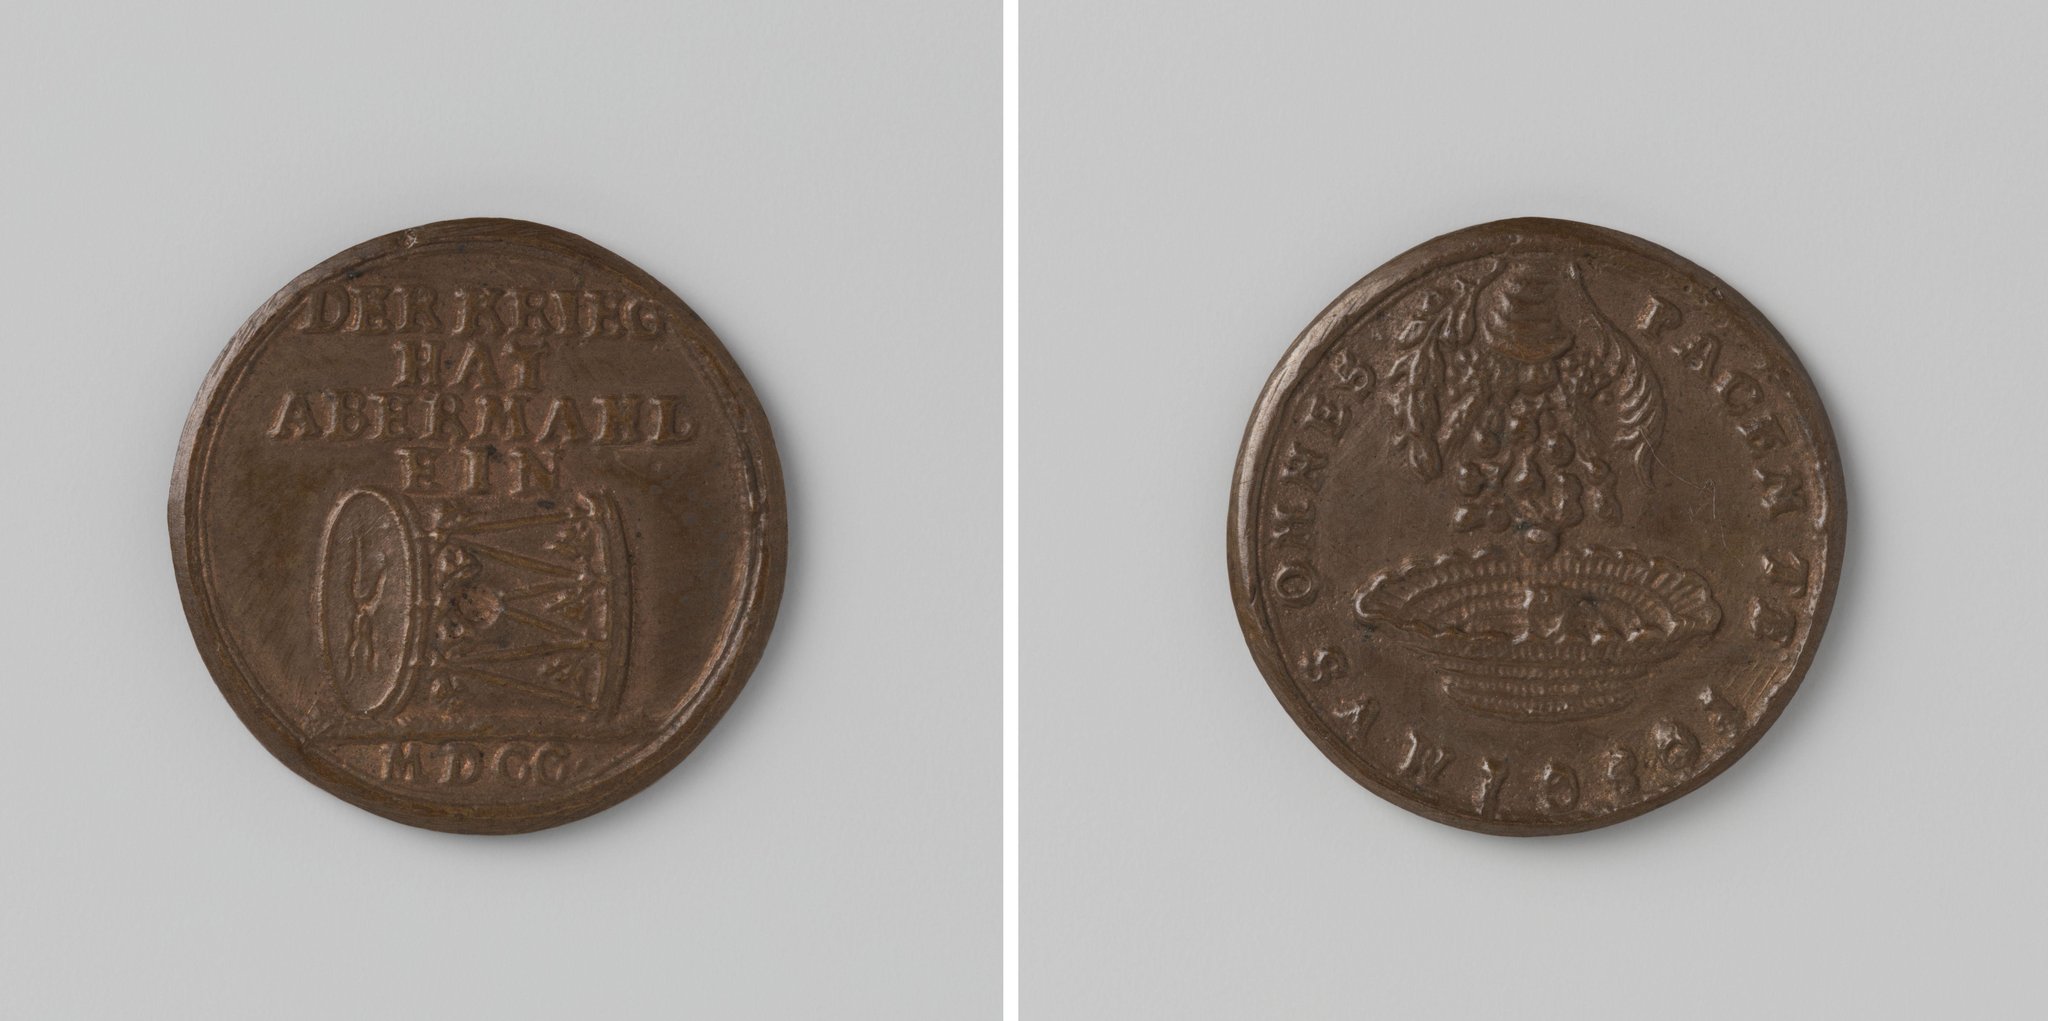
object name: history medal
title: Vrede van Travendal tussen Denemarken en Zweden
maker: christian wermuth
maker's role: medailleur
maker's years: 1661-1739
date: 1700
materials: bronze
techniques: striking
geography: gotha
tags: faeröer, zweden, travendal, sleeswijk-holstein, vrede van travendal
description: Bronzen penning. Voorzijde: trom met gat erin onder opschrift; afsnede: jaartal. Keerzijde: hoorn van overvloed met olijf- en palmtak, die geleegd wordt boven korf waar nog klein gat in zit binnen omschrift